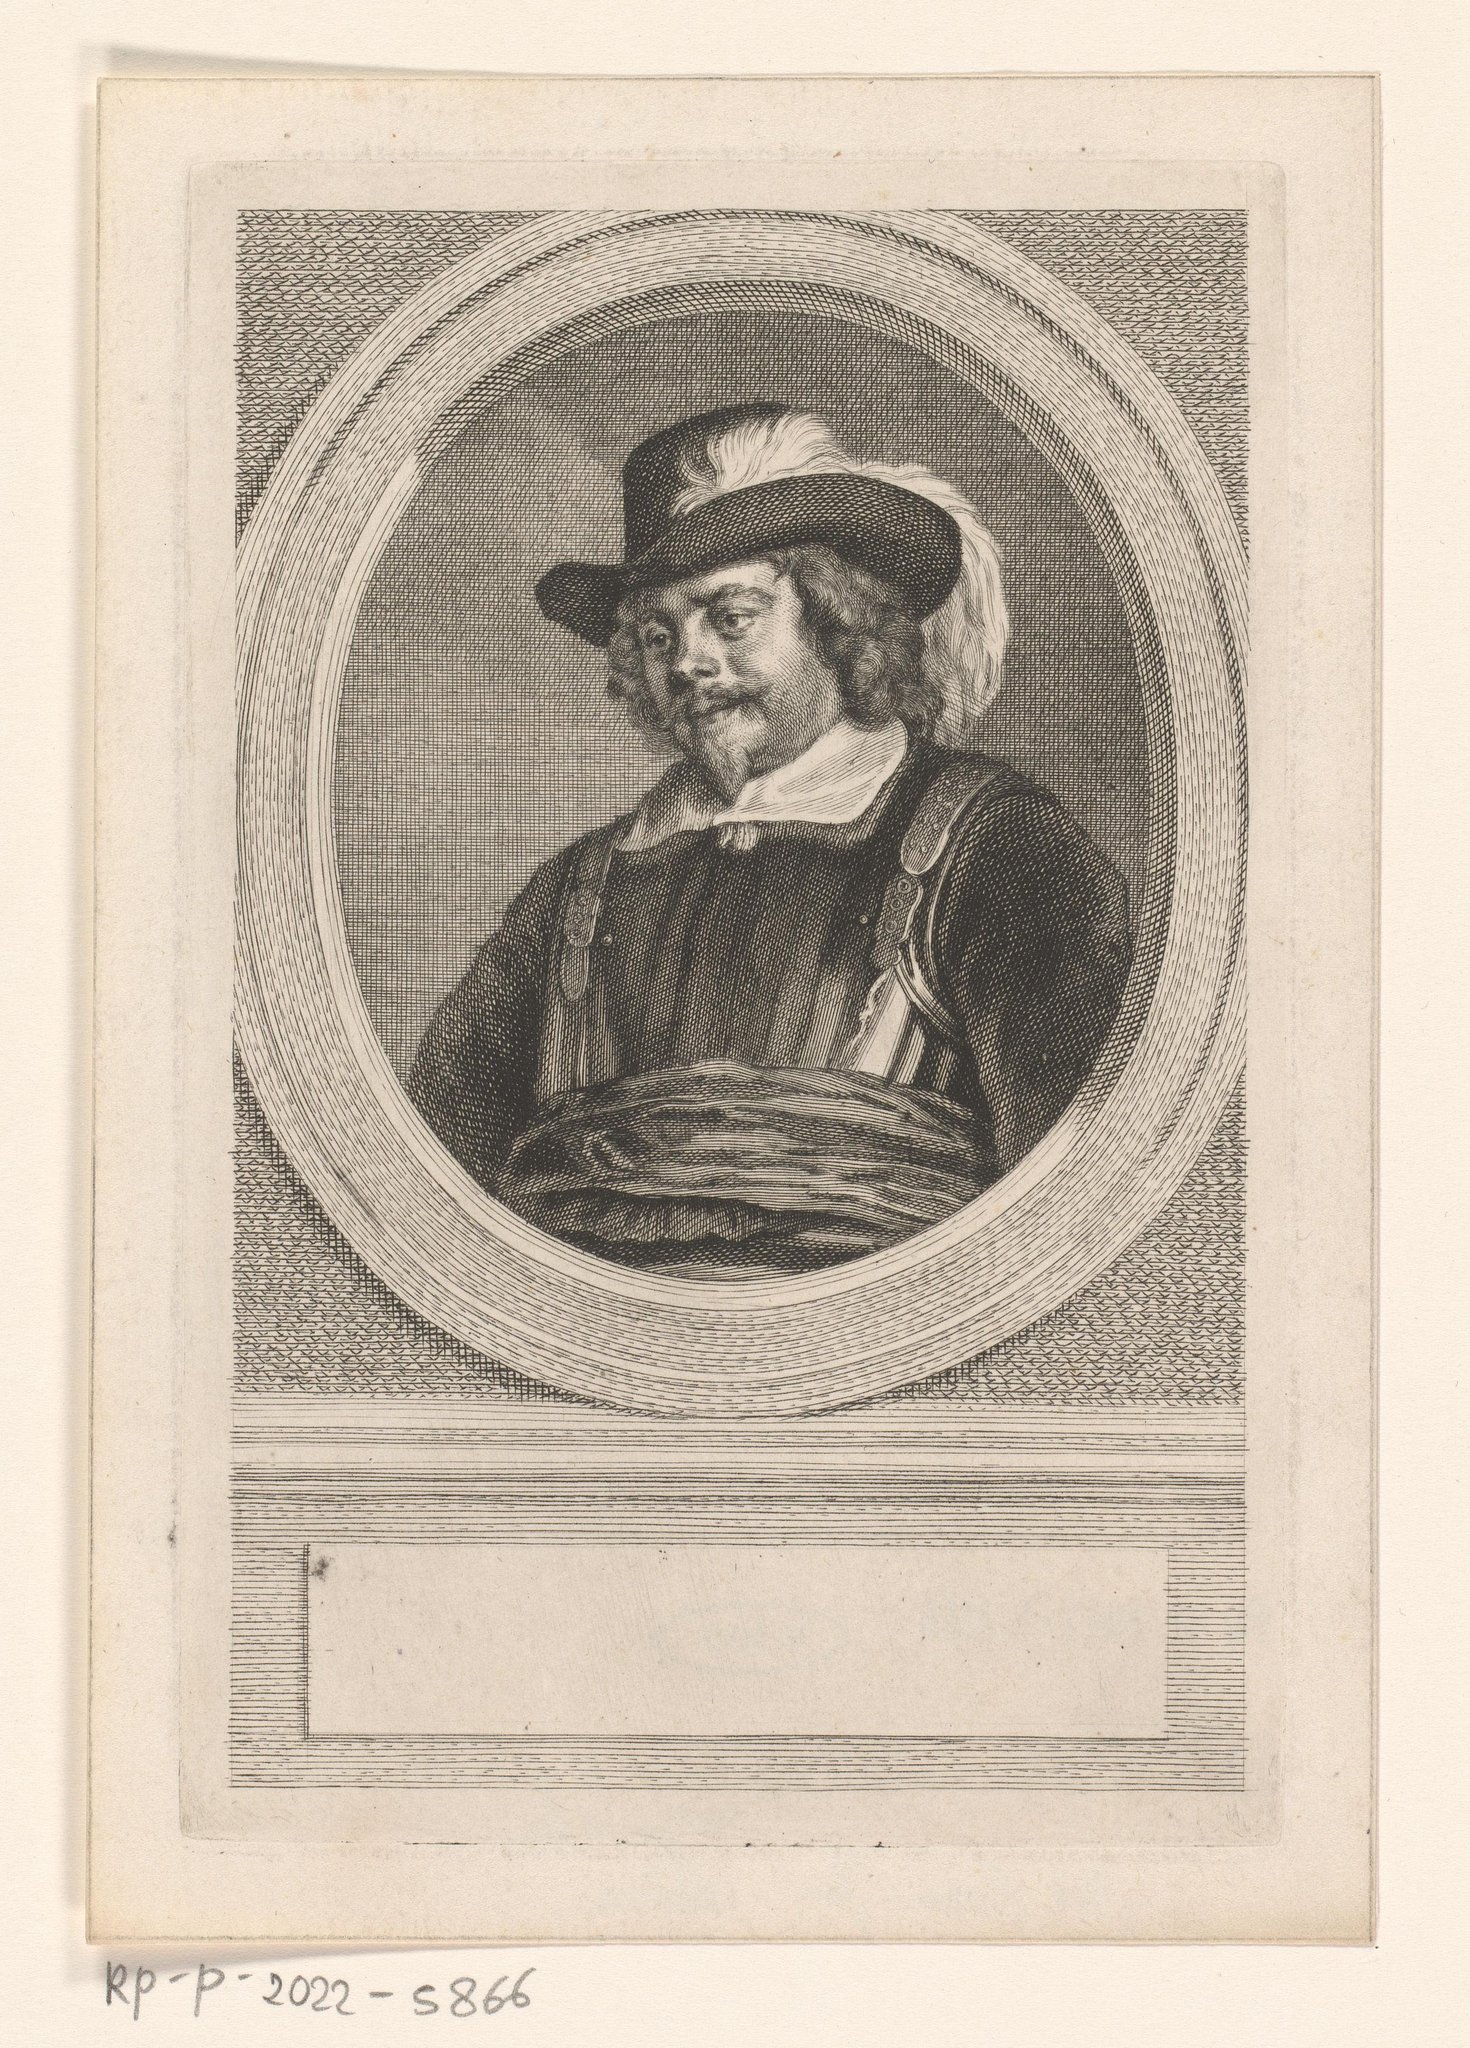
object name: book illustration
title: Portret van Cornelis Witsen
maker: jacob houbraken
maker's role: draughtsman, print maker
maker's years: 1698-1780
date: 1779-1780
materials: paper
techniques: engraving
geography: amsterdam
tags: amsterdam, cornelis witsen, mayor, burgomaster, historical persons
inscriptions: collector's mark: Lugt 2228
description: Latere staat prent waarschijnlijk uit: Wagenaar, Jan. Amsterdam in zyne opkomst, aanwas, geschiedenissen, (...). Amsterdam: Isaak Tirion, 1765, vol. 7. De prenten zijn tussen 1765 en 1786 in dit boek gevoegd. Zie: Compleete lyst of register van alle de portraiten en plaaten, (...). Amsterdam: A. van der Kroe en A. Capel, 1786.